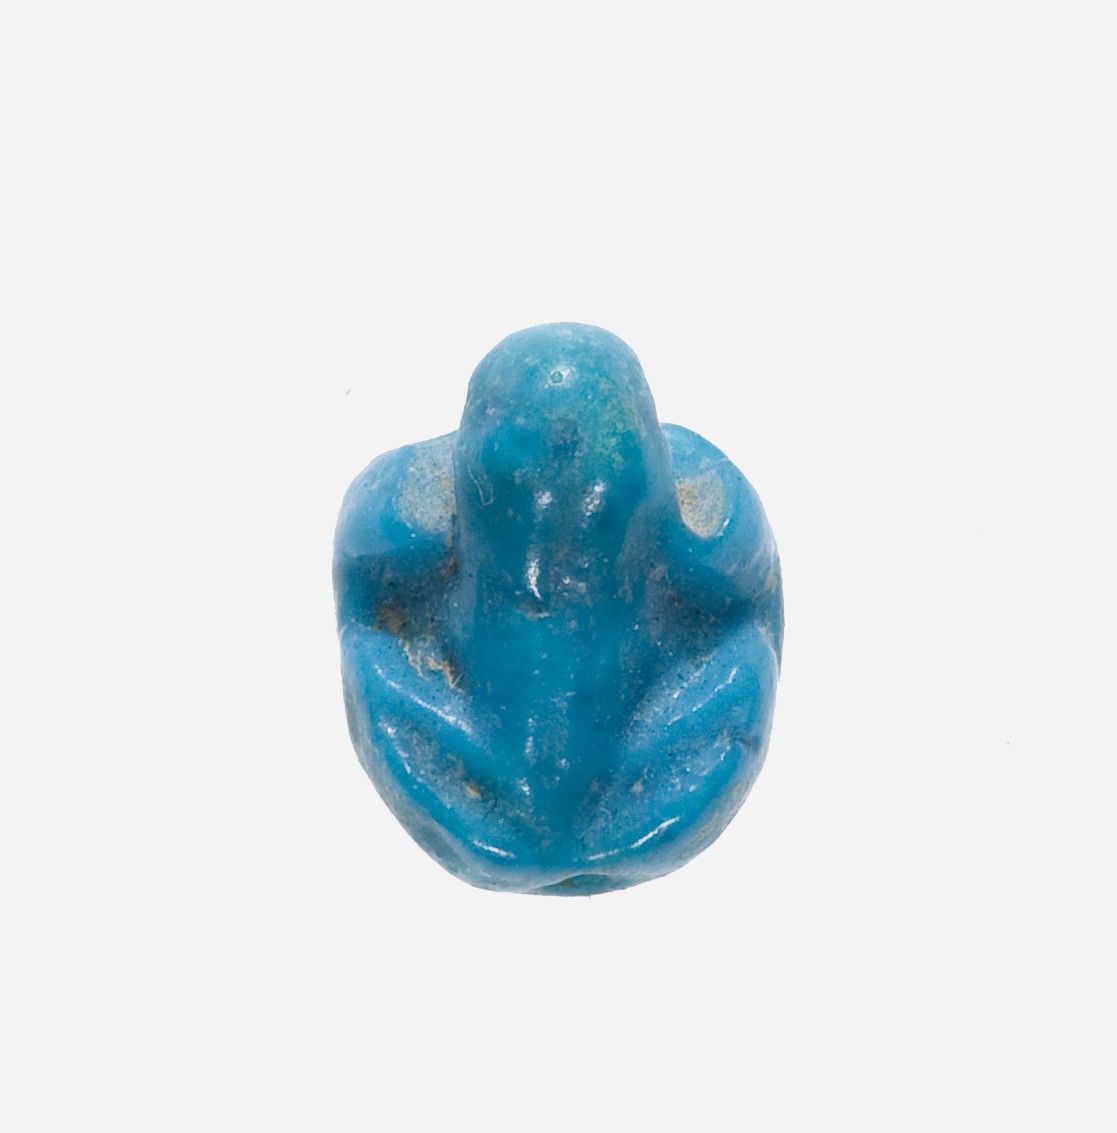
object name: seal amulet, frog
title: Frog Seal Amulet with a City Hieroglyph (?) on the Base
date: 1390-1352 BCE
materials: faience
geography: egypt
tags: frogs